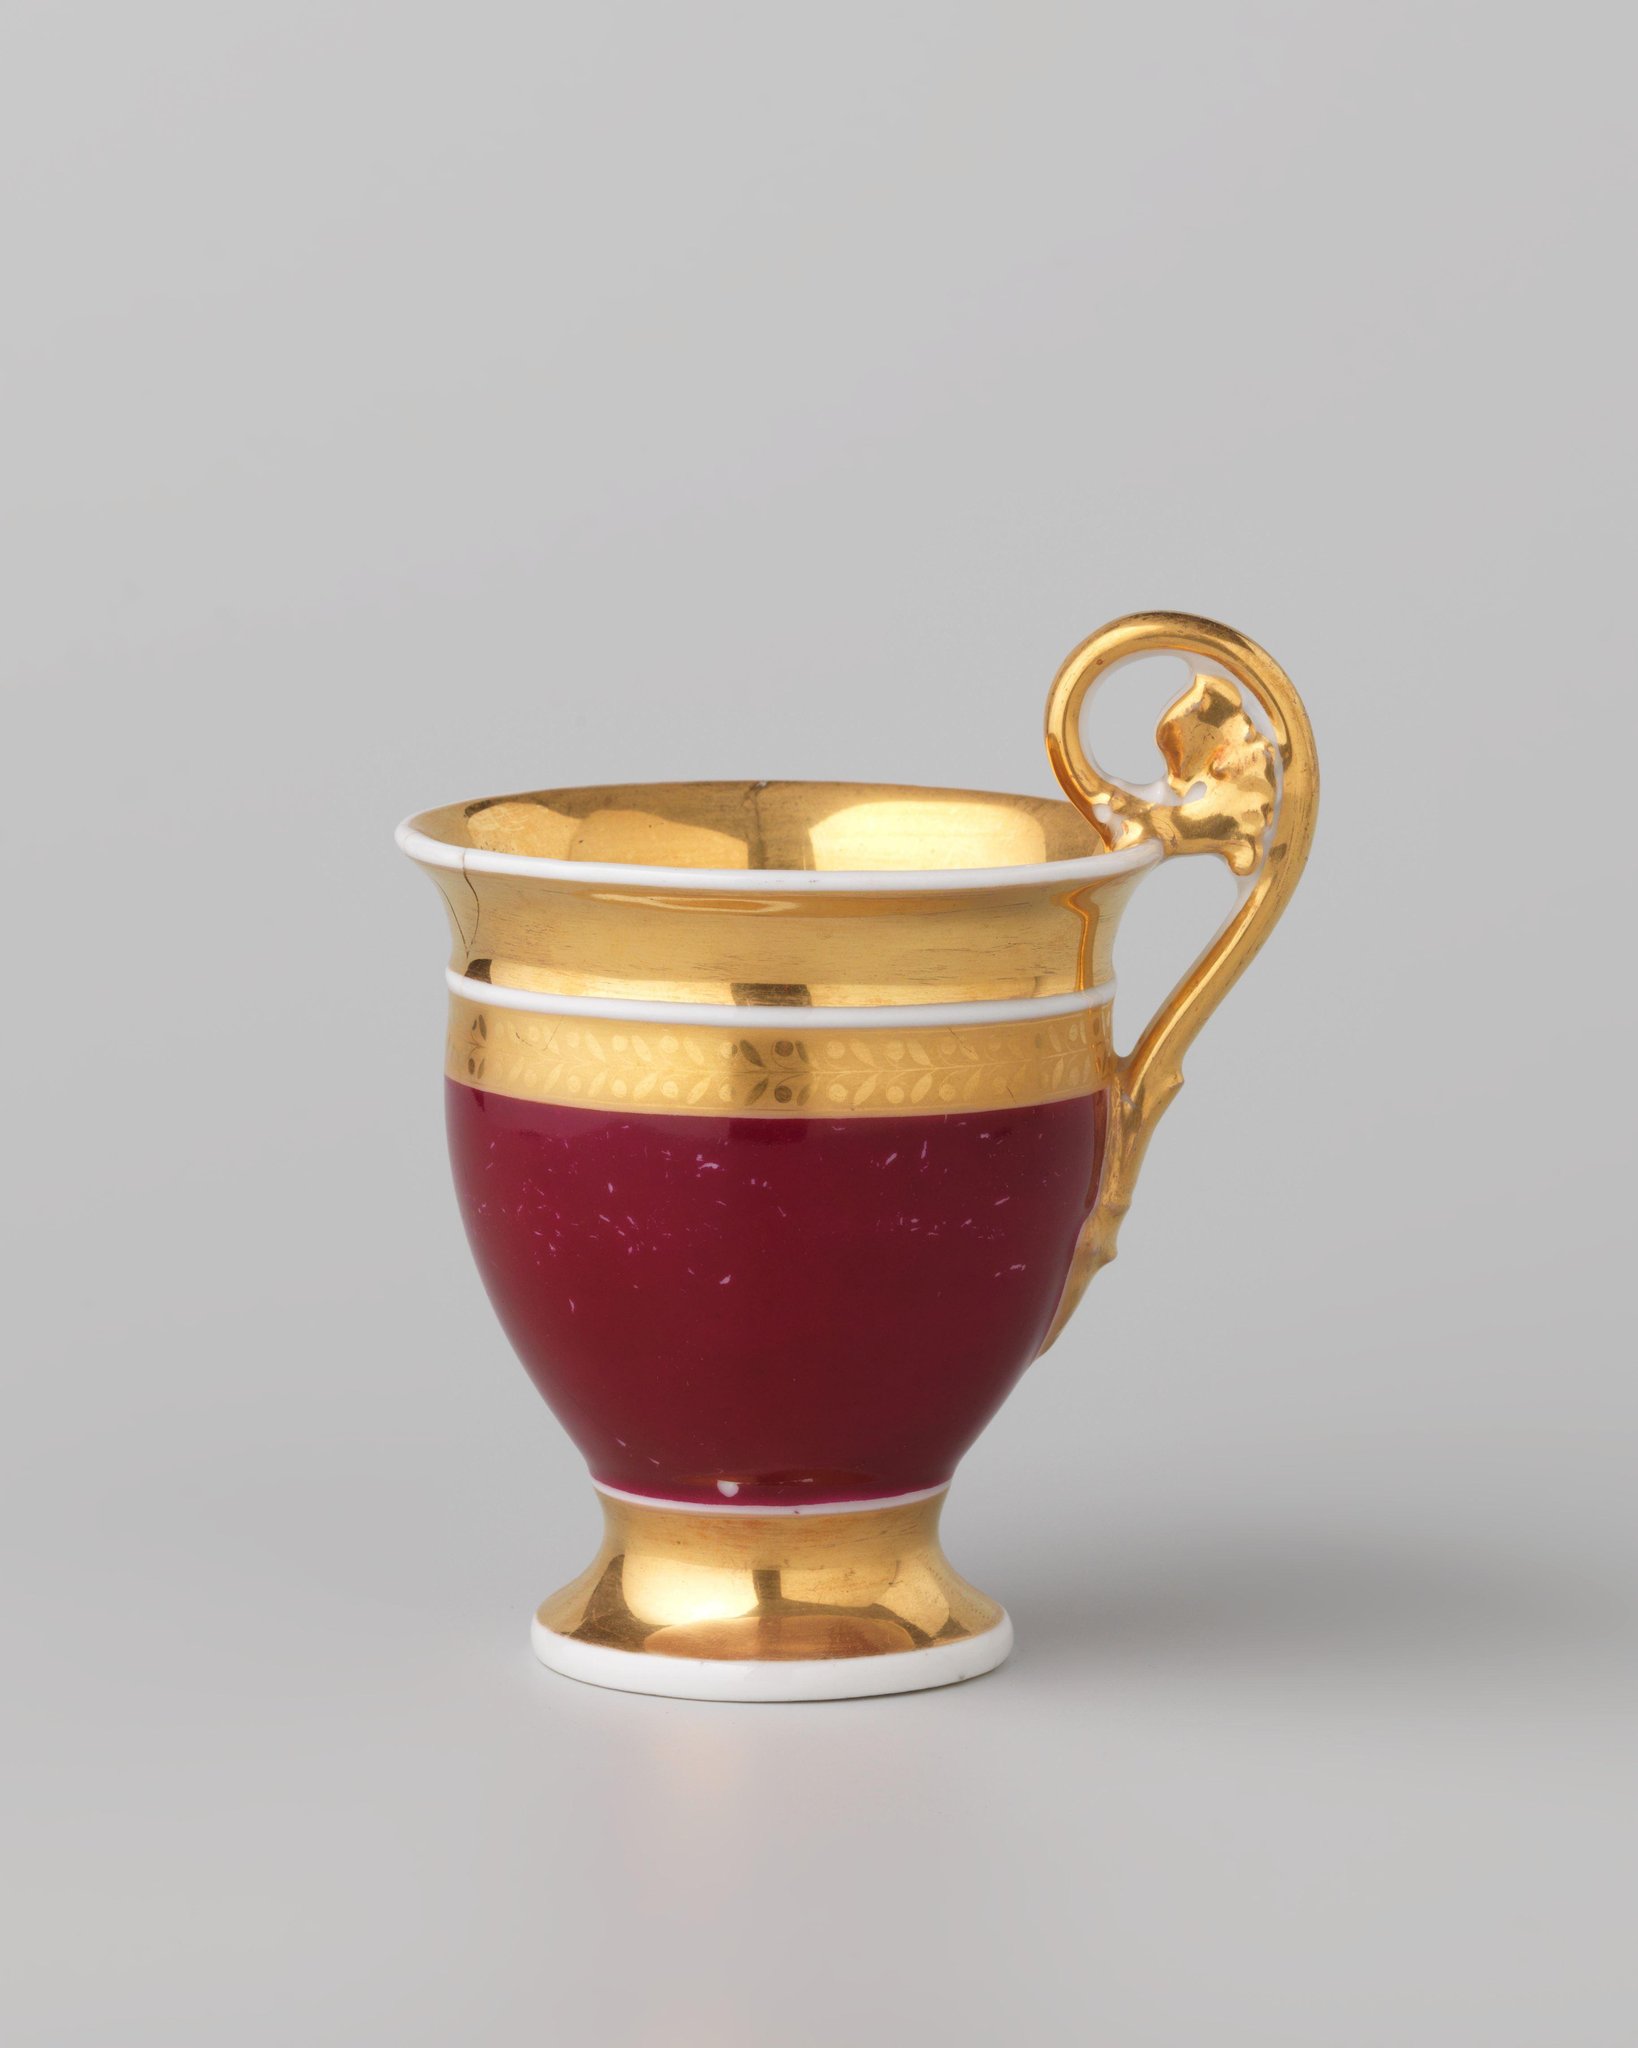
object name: service set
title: Cup with gold borders on a red ground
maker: Anonymous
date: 1800-1824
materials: glaze, gold, paint, porcelain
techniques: firing, forming, gilding, turning, vitrification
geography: france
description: Kop van porselein op spreidende voet en met een hoog, gekruld oor, bedekt op het glazuur met rood en goud. De buitenwand is bedekt met rood en de voet, rand, oor en een deel van de binnenwand met goud. Op de buitenrand een bloemrank in één van de gouden banden. Empire.